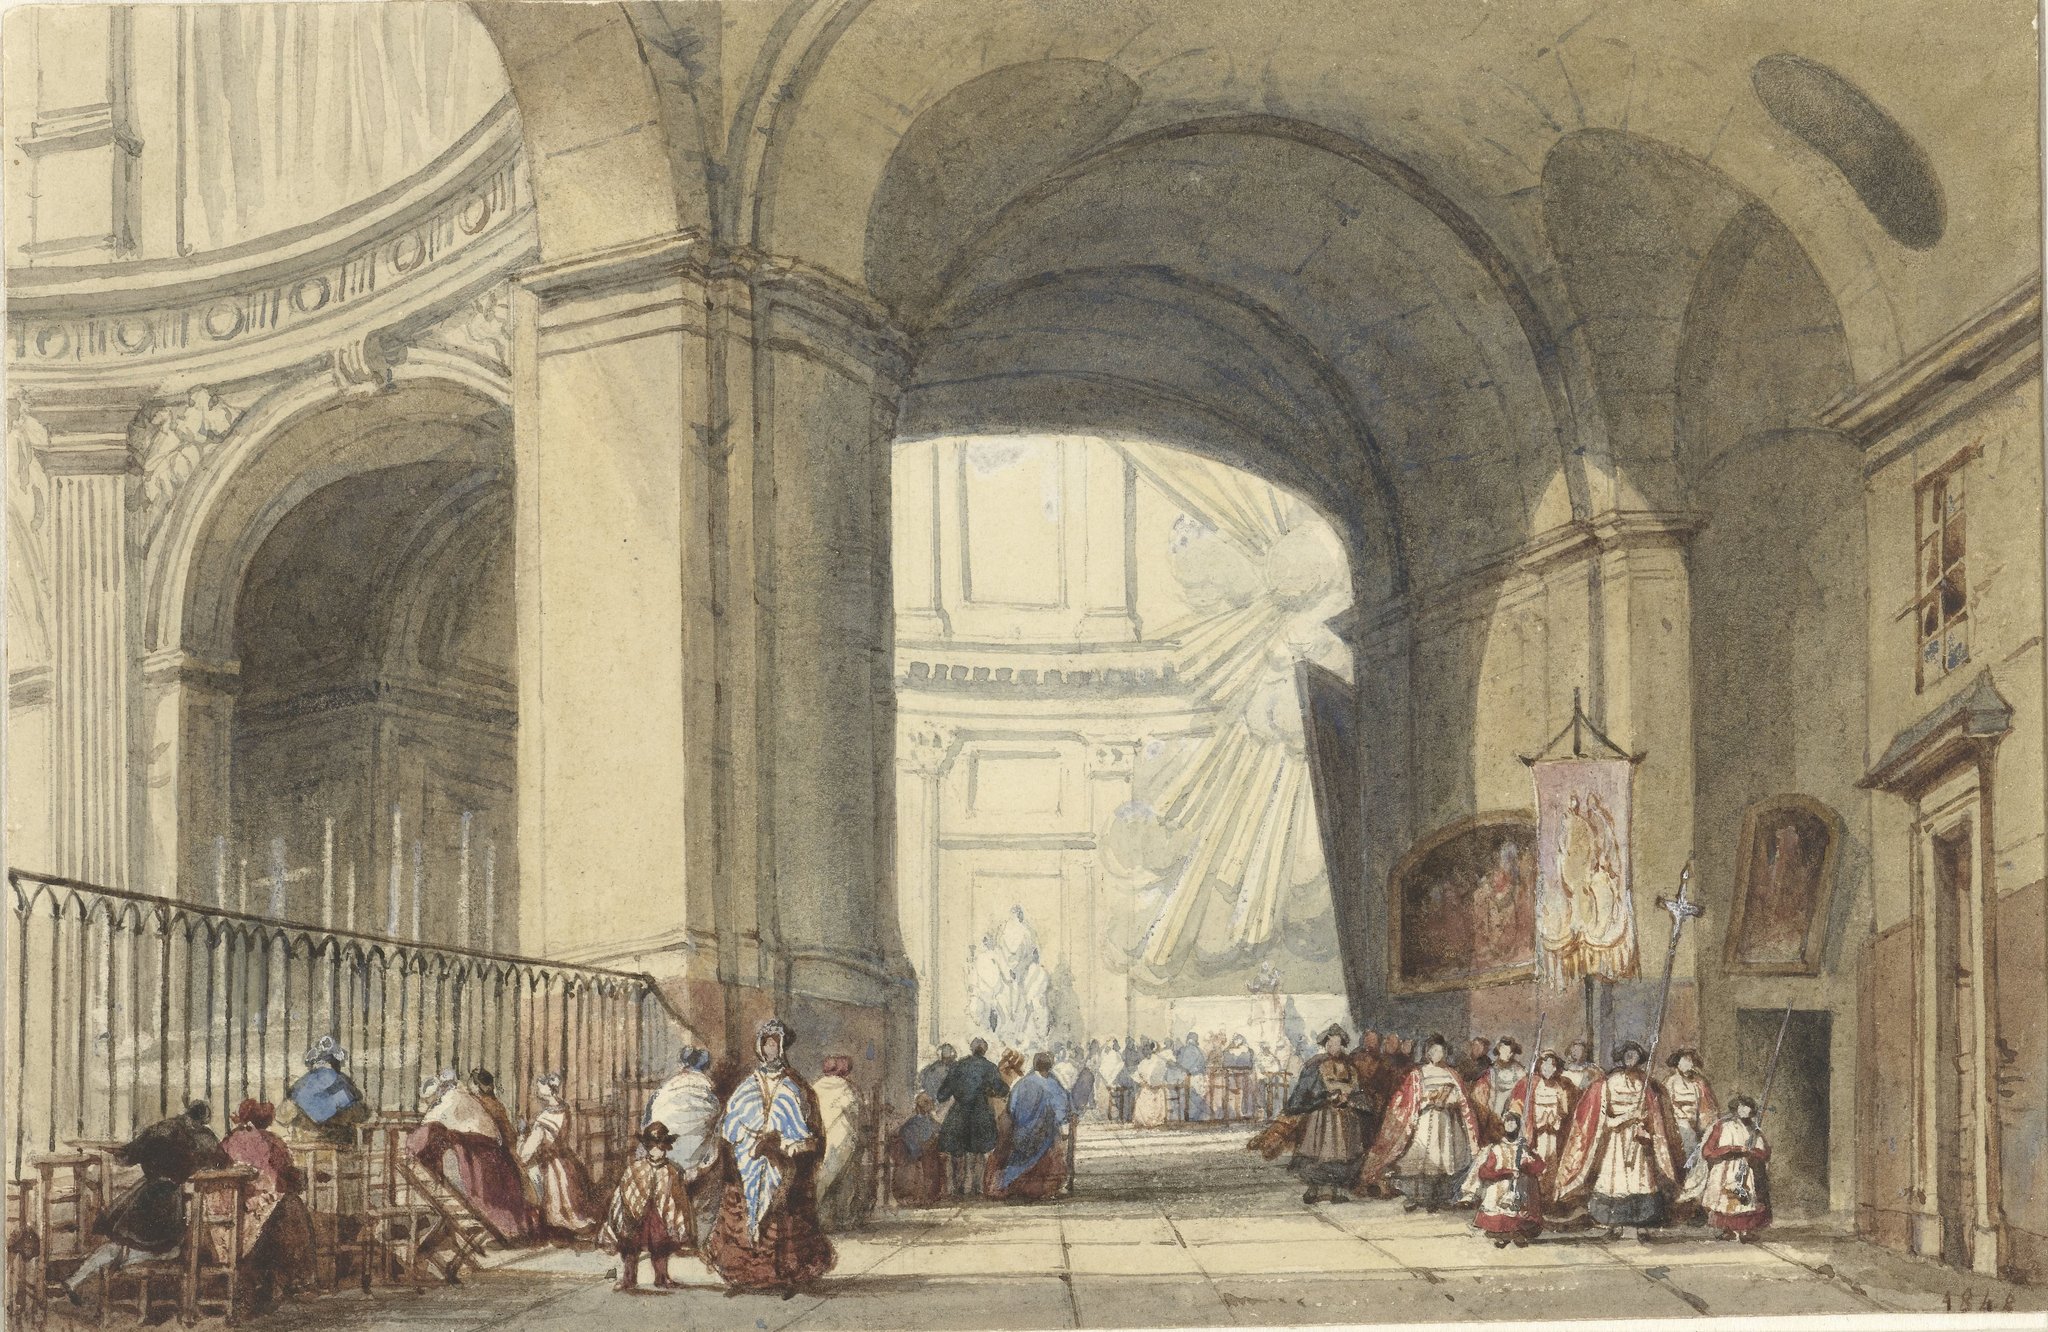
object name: drawing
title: Interieur van de S. Roche te Parijs, met een processie op de voorgrond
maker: eugène louis lami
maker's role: draughtsman, print maker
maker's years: 1800-1890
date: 1848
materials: paper, pencil, watercolor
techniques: brush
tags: roman catholic church, interior of church, procession ~ christian religion